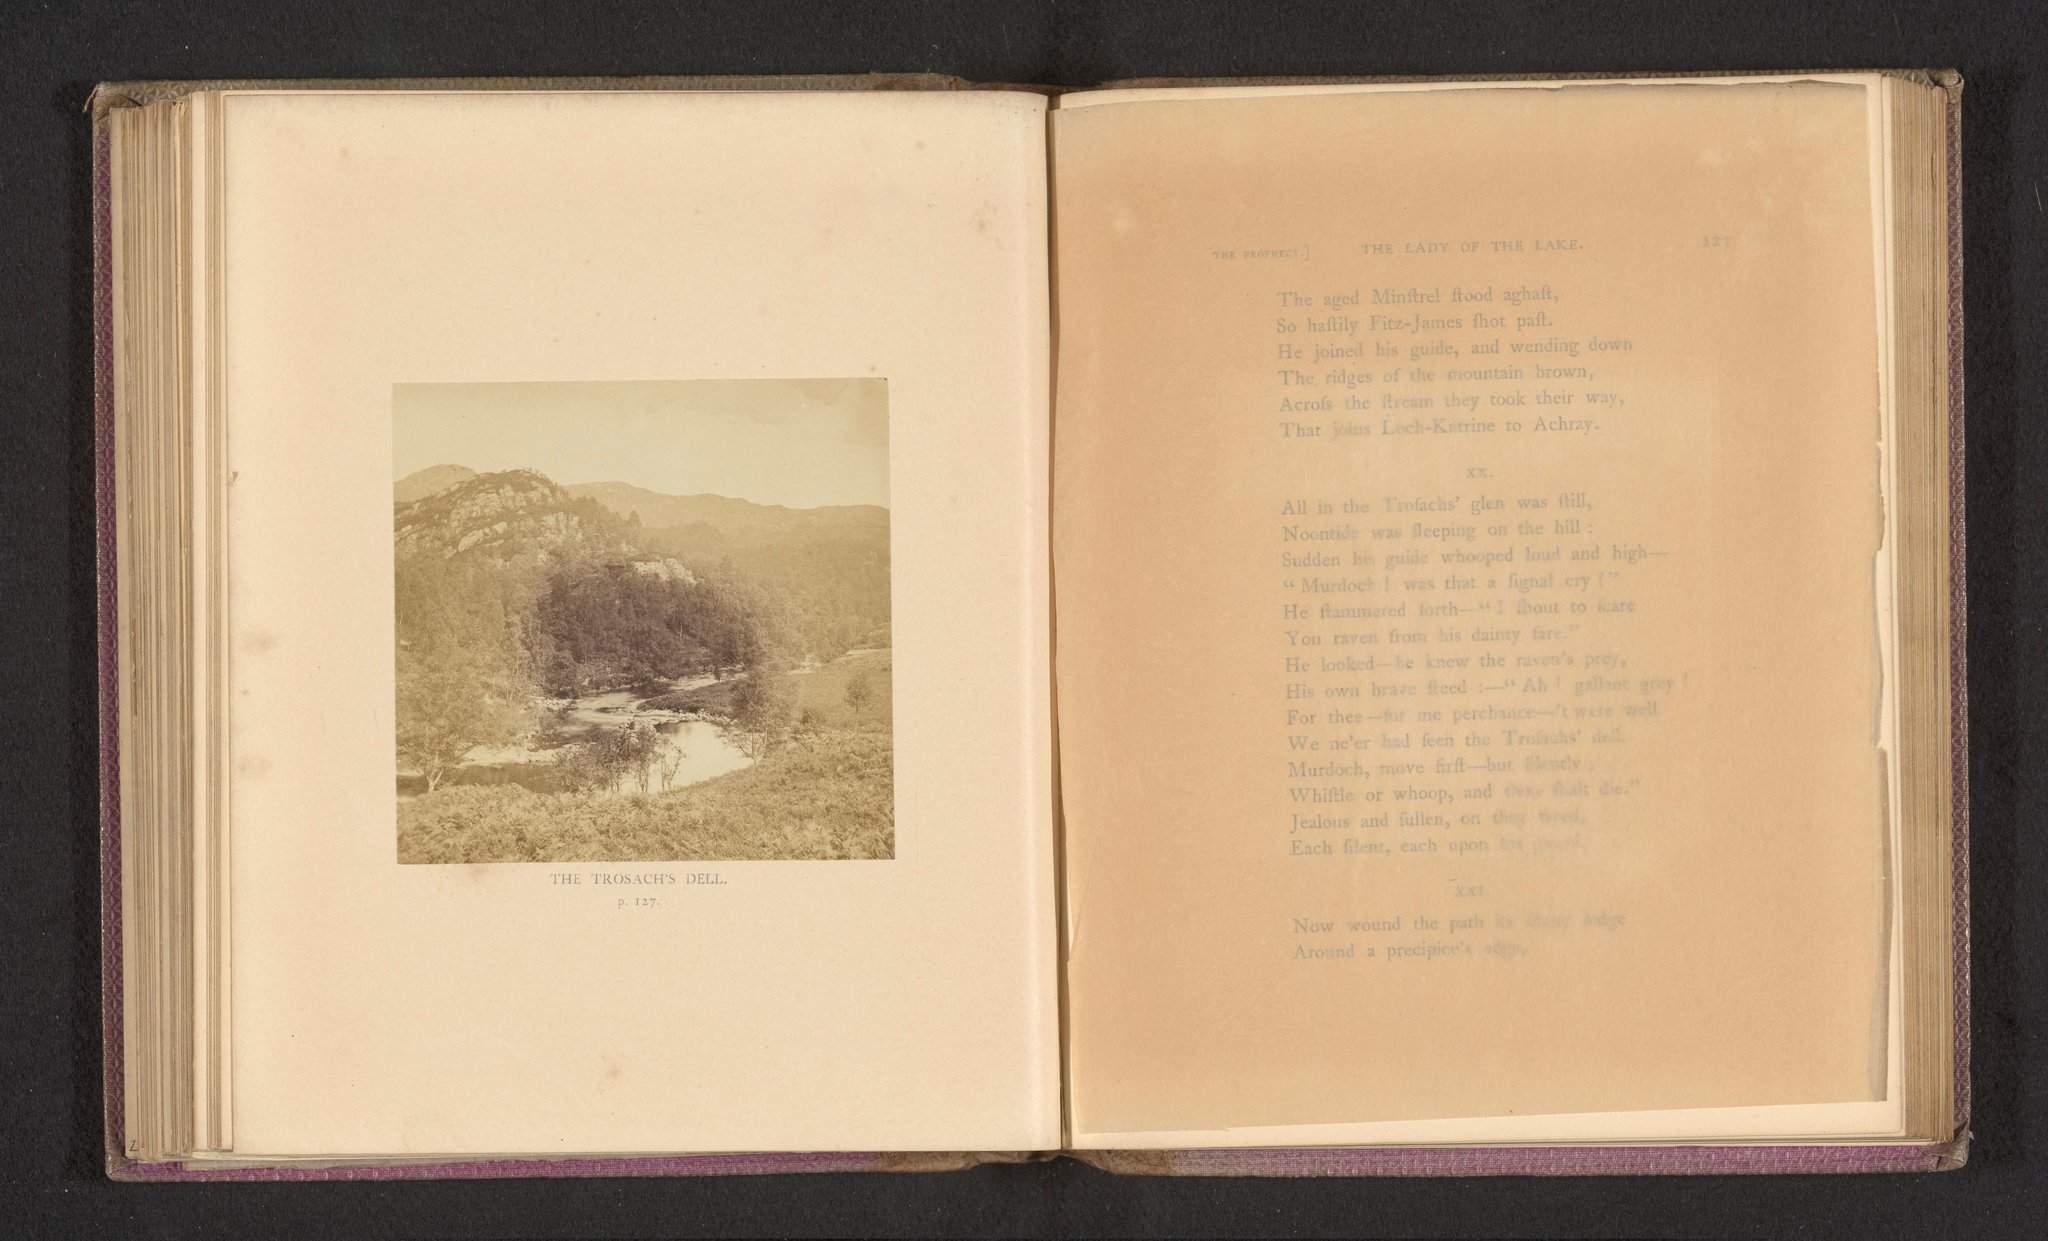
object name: photograph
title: Gezicht op de Trossachs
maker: thomas ogle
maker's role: fotograaf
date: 1853-1863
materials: photographic support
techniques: albumen print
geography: trossachs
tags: dale, valley, river, mountains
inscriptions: number: ‘P. 127.’